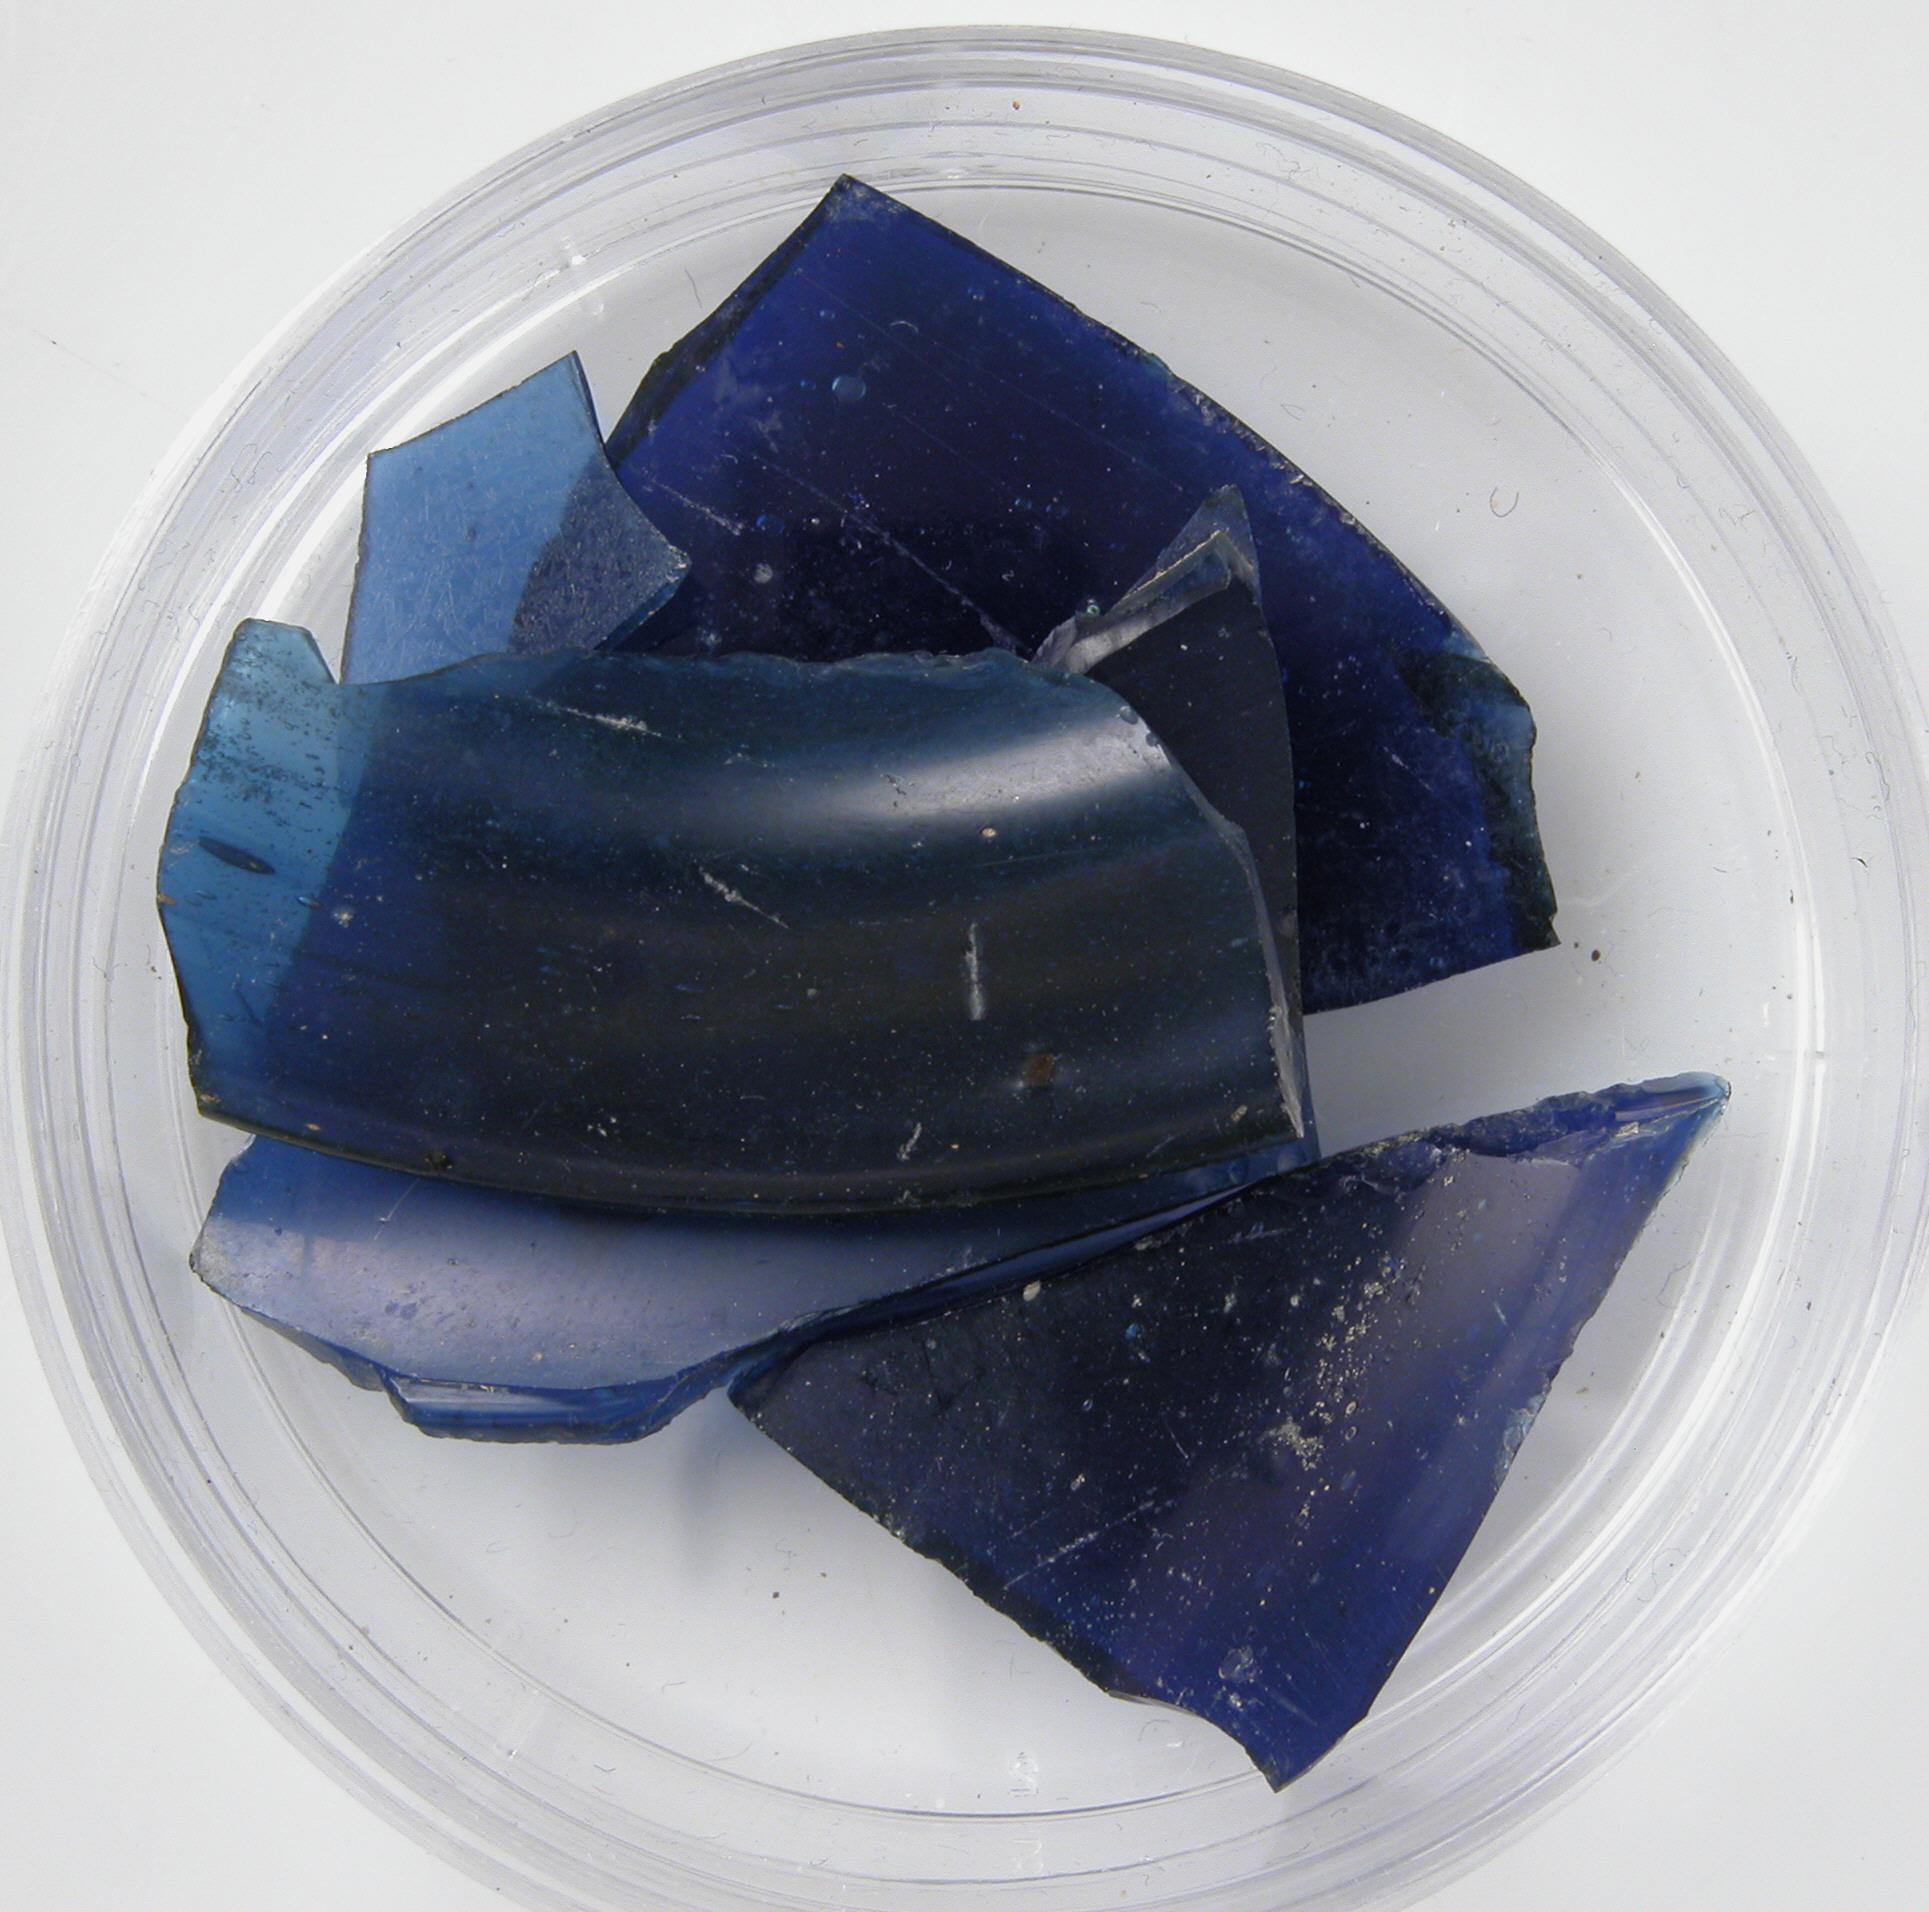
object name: fragment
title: Glass Fragments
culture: coptic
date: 301-700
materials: glass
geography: egypt